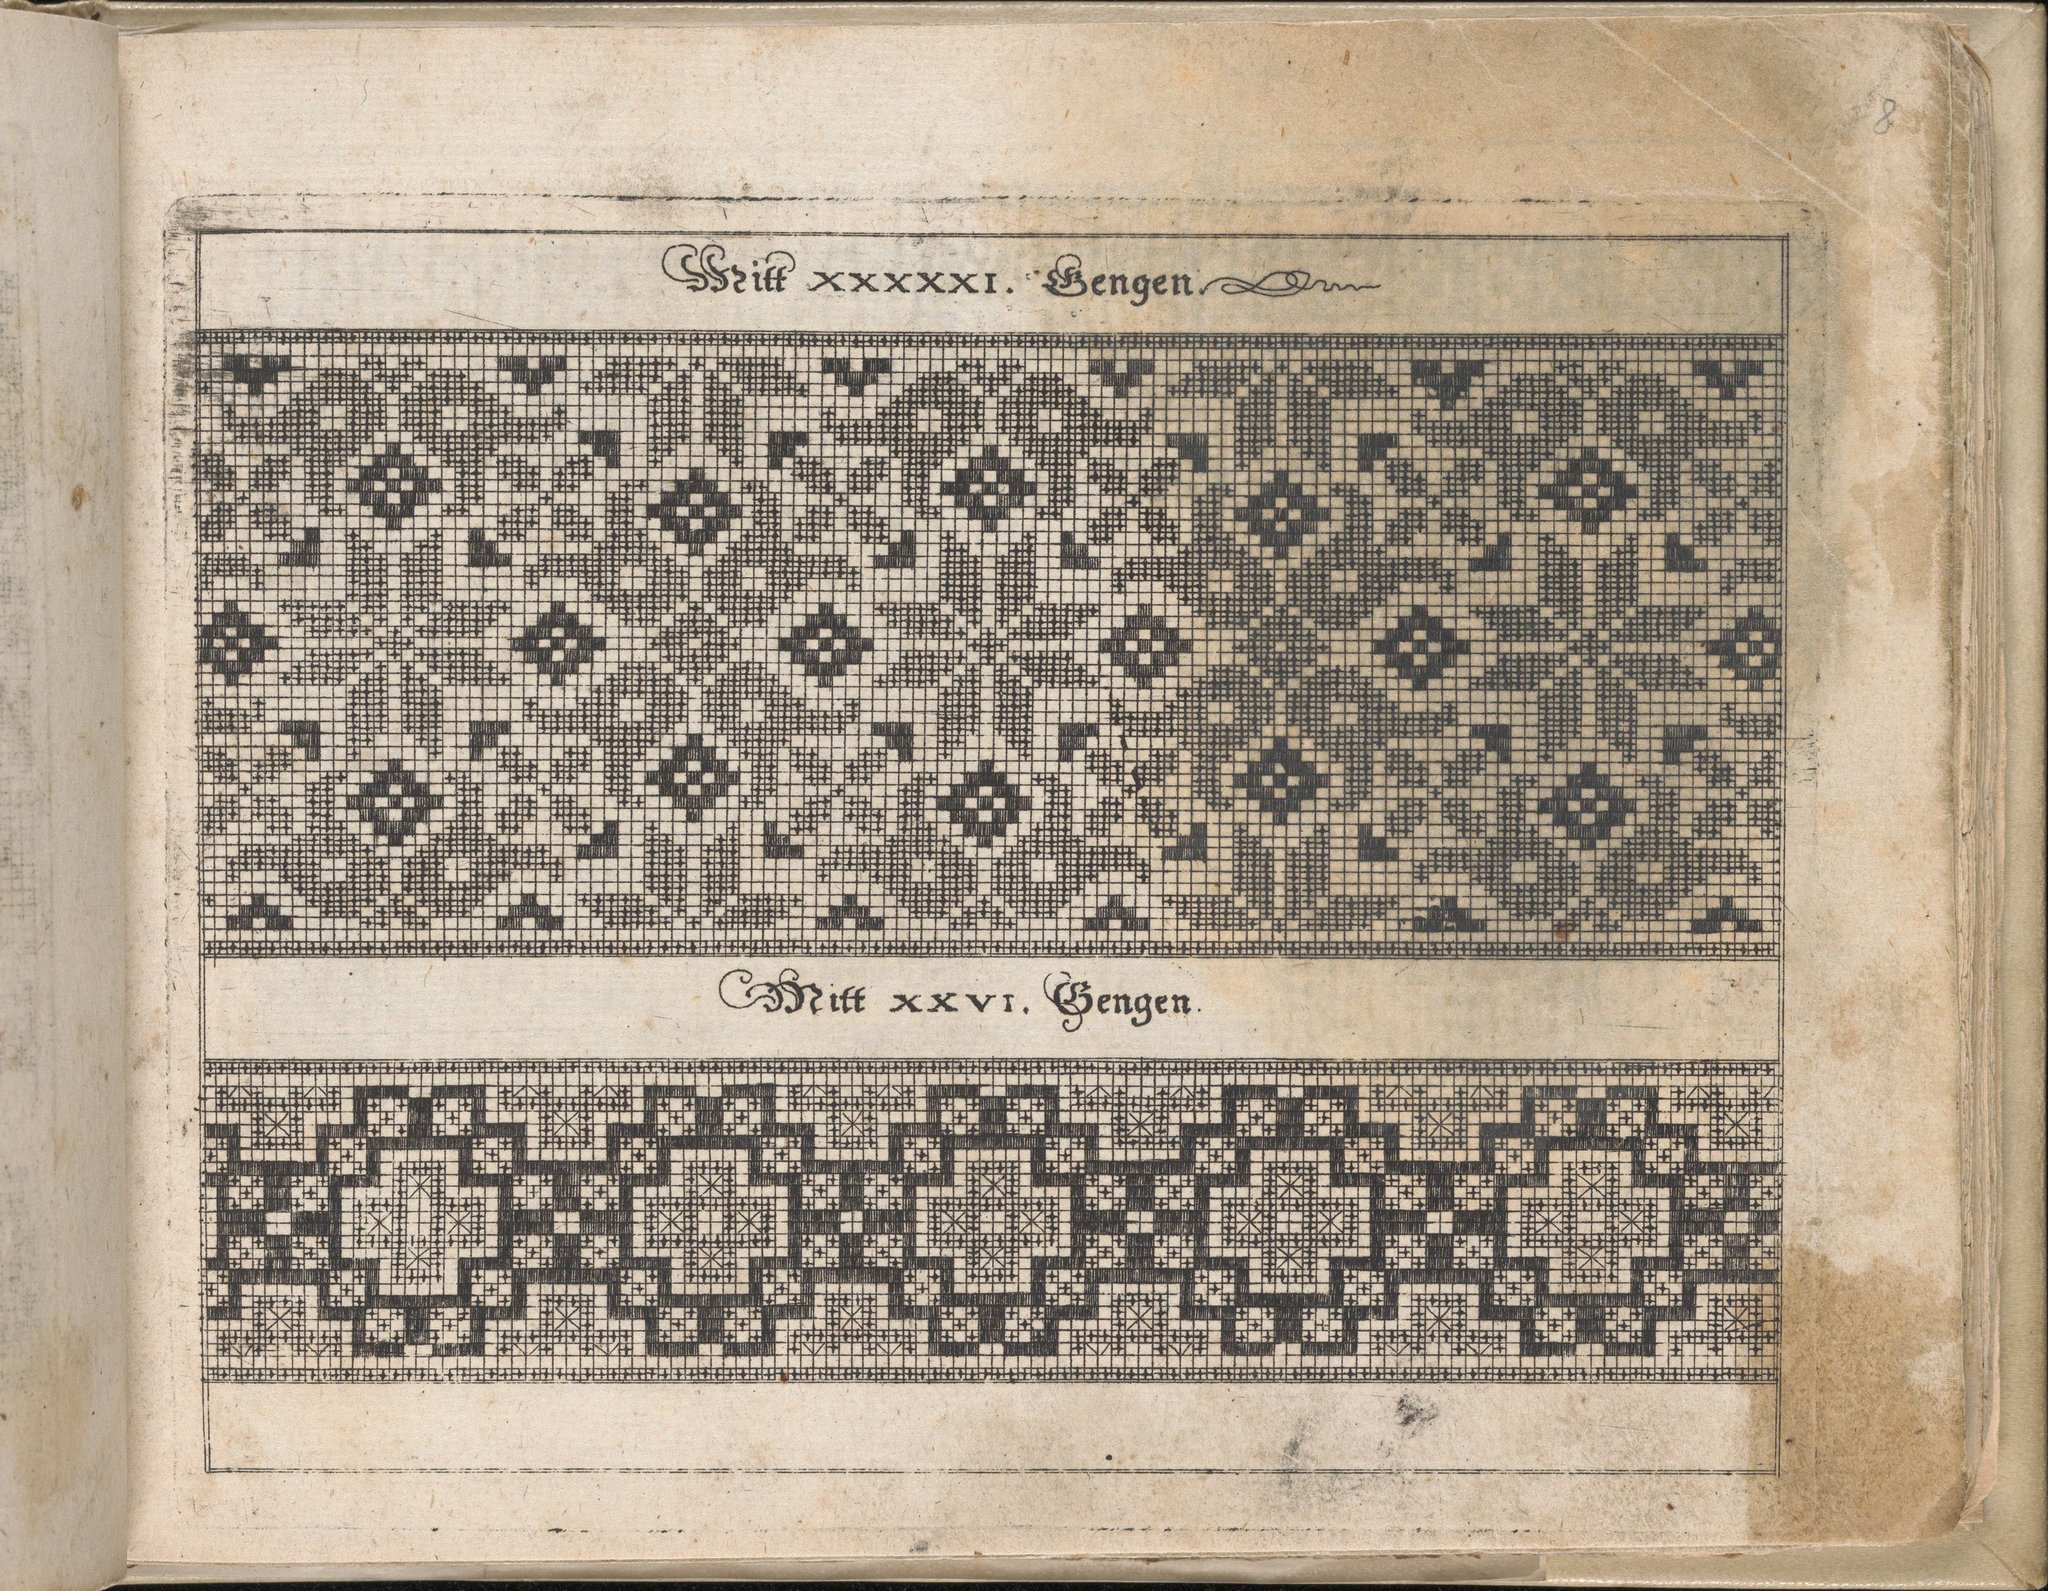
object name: book print ornament architecture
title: Schön Neues Modelbuch (Page 13 recto)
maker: johann sibmacher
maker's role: designer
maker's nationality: german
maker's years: 1590-1611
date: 1597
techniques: etching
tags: ornament